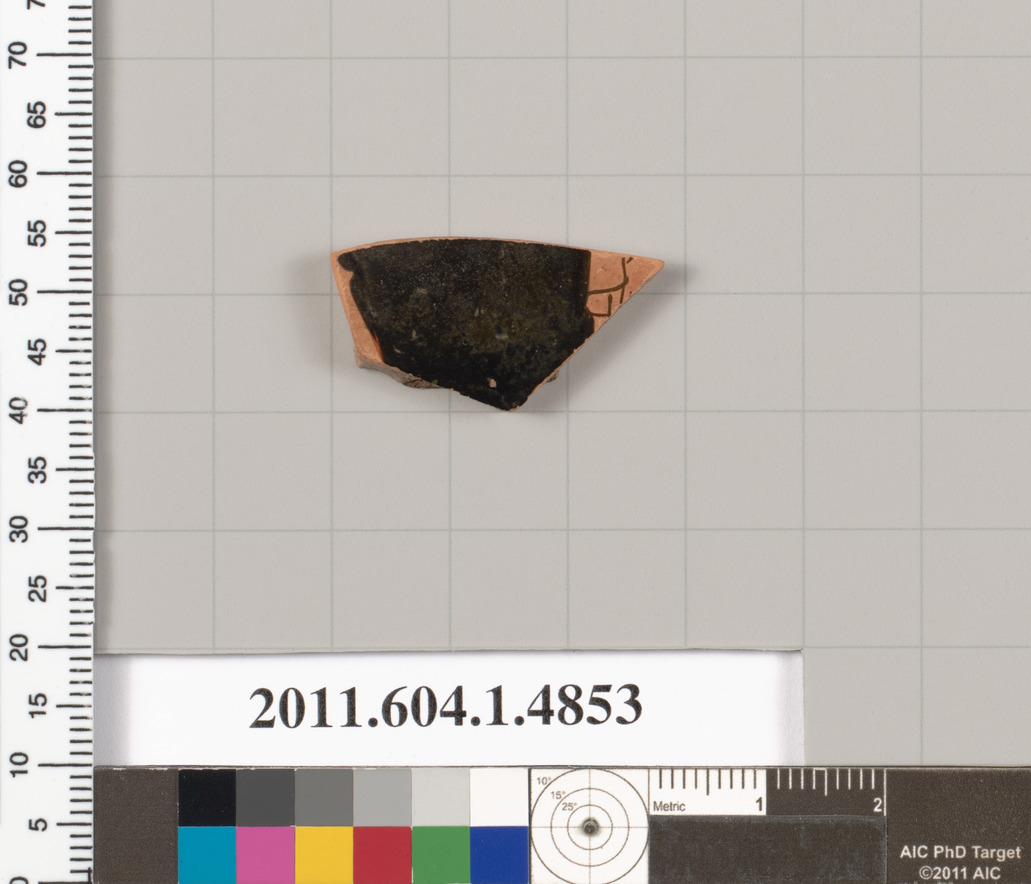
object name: kylix fragment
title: Terracotta fragment of a kylix (drinking cup)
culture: greek, attic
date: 475-451 BCE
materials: terracotta